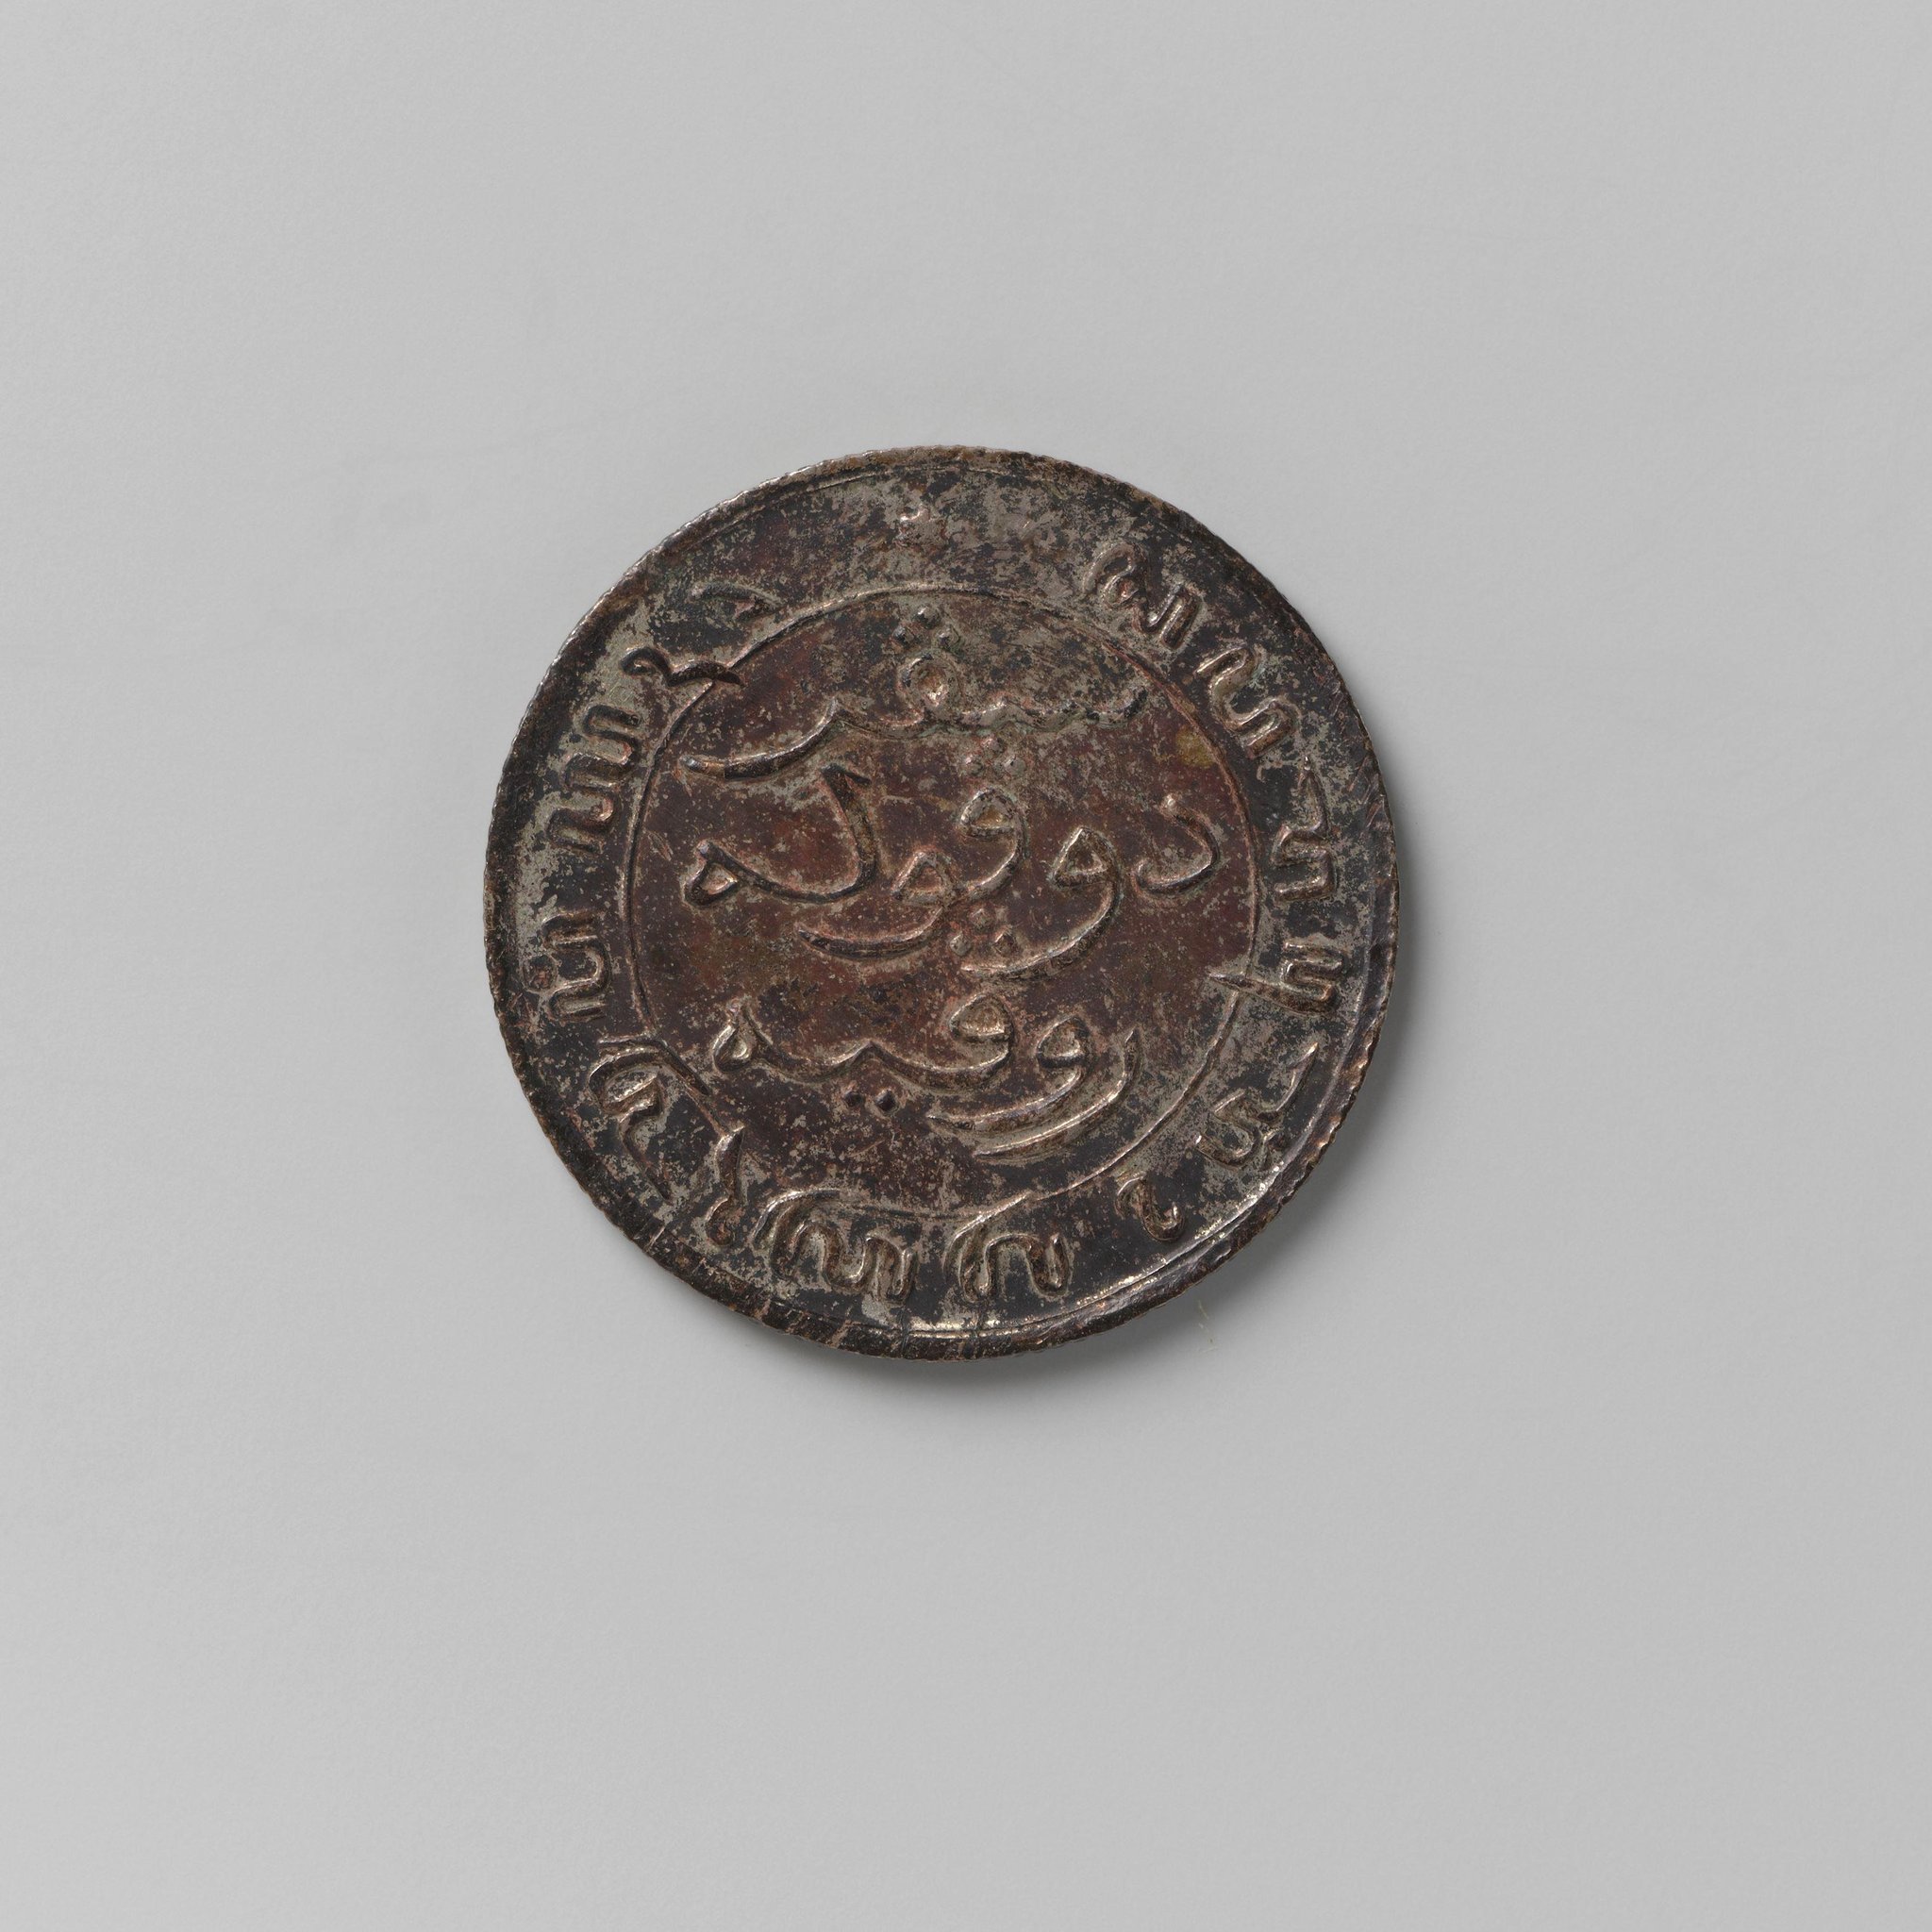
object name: coin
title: 1/20 gulden van Nederlands Indië, 1855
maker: willem iii (koning der nederlanden)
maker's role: koning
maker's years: 1817-1890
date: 1855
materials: silver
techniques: striking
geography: utrecht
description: Zilveren munt. Voorzijde: tussen waarde-aanduiding 1/20 G gekroond rijkswapenschild. Boven kroon landsaanduiding en onder wapenschild jaartal. Keerzijde: drieregelig Maleis opschrift in Arabische tekens, waaromheen omschrift in het Javaans. Kartelrand.